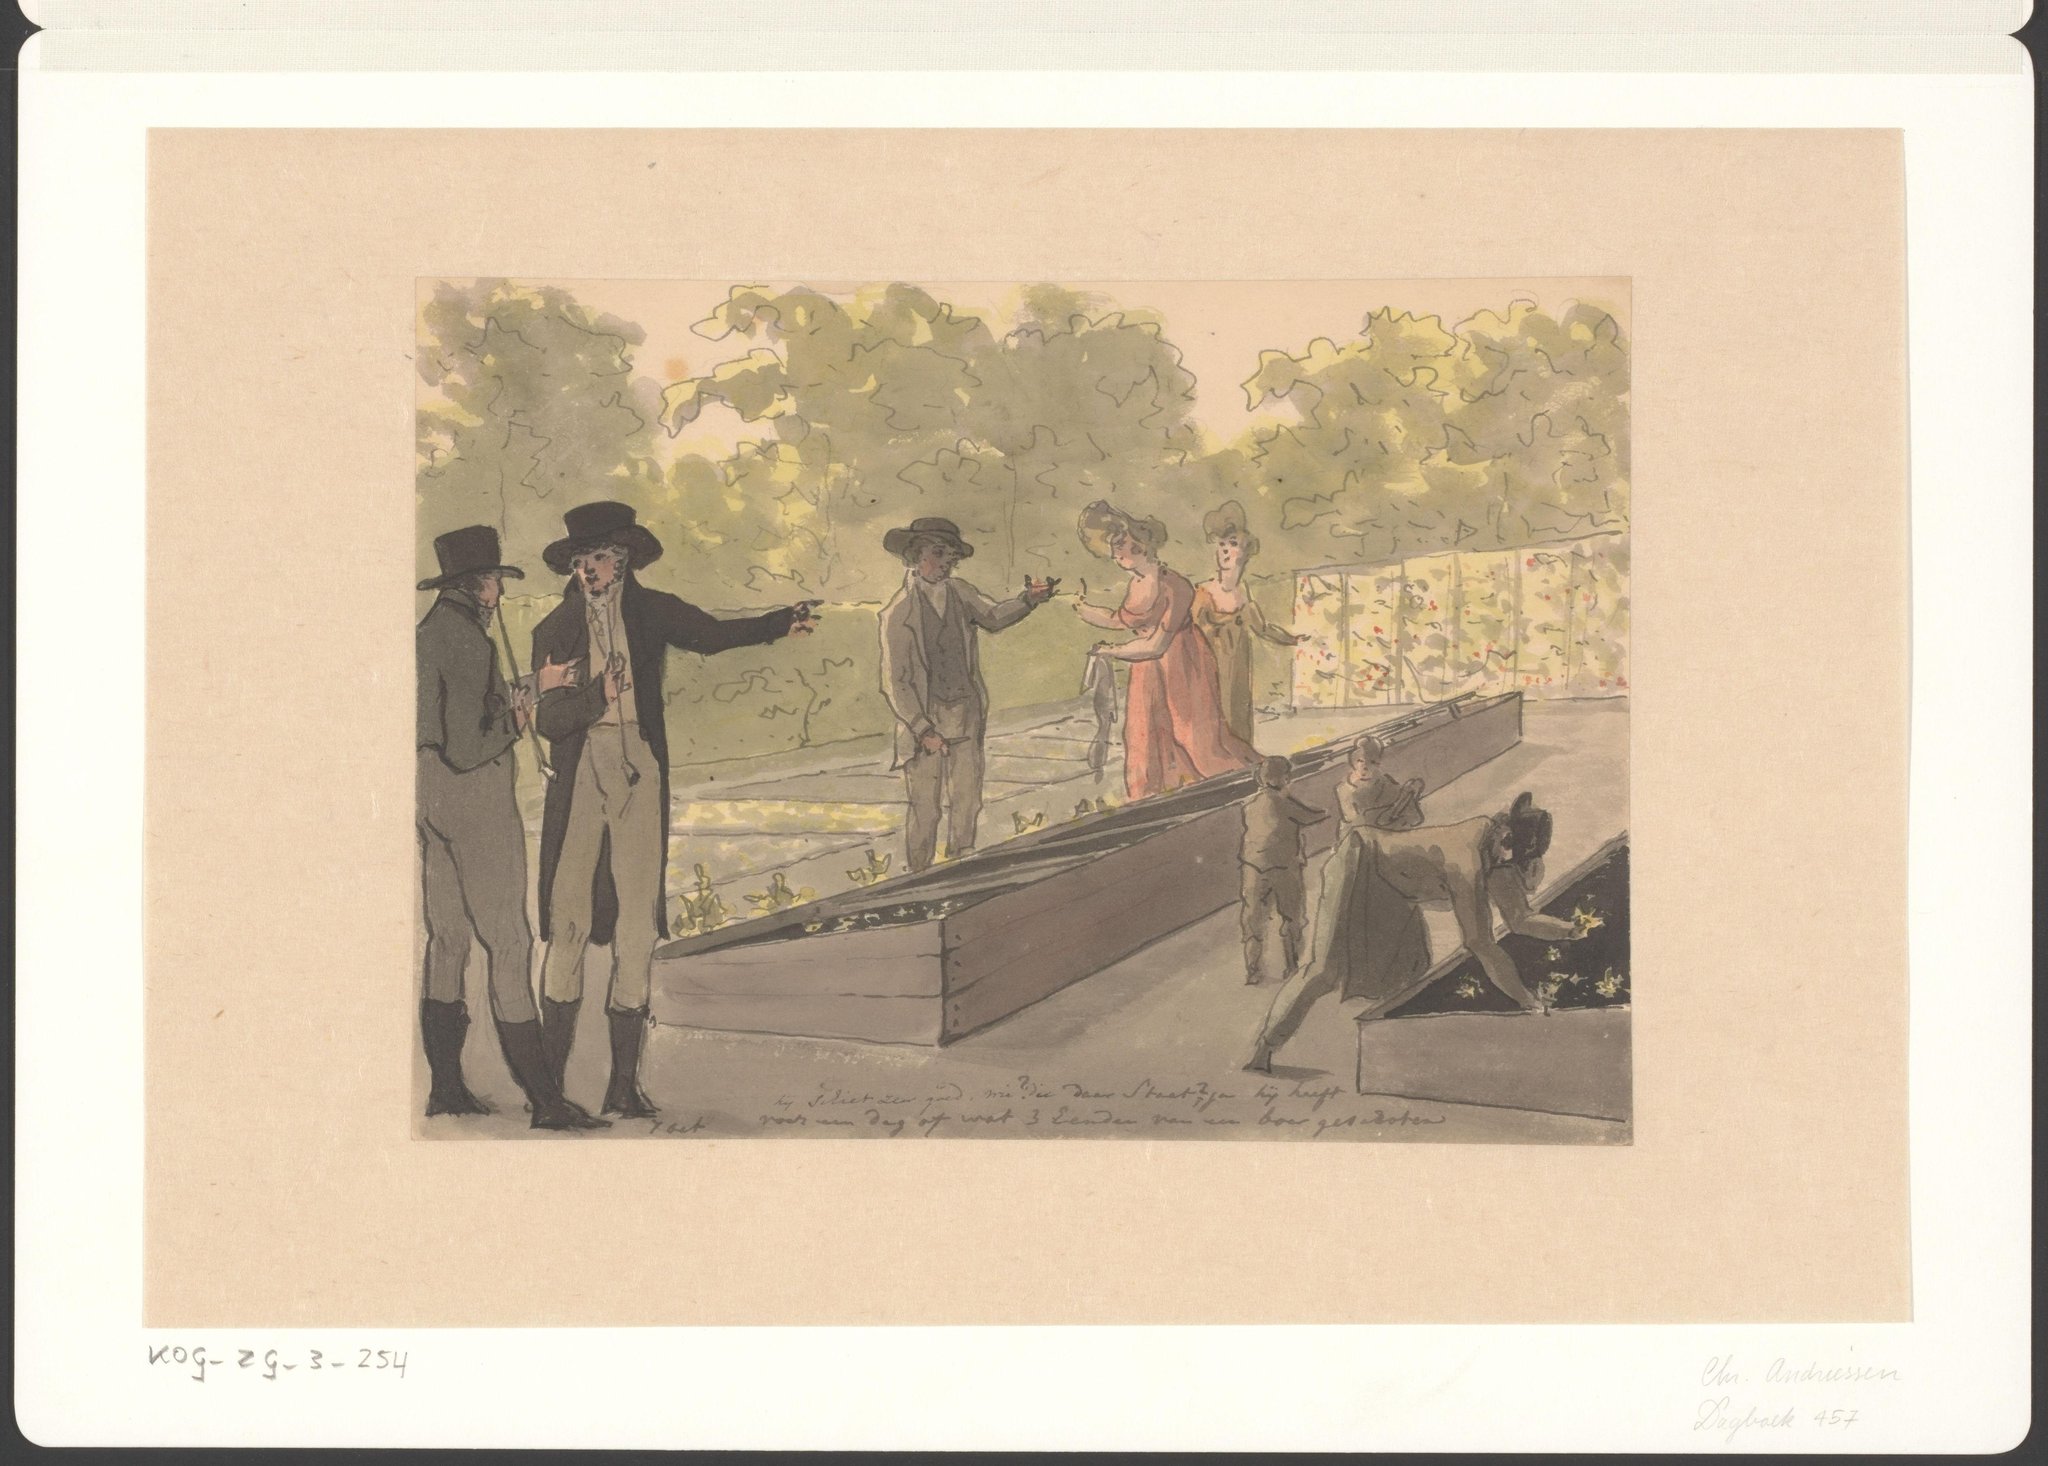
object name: drawing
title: Bezoek aan een kwekerij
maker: christiaan andriessen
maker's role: draughtsman, print maker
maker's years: 1775-1846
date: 1805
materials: ink, paper, pencil, watercolor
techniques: brush, pen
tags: amsterdam, print maker, draughtsman, christiaan andriessen, gardening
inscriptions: inscription: ‘7 oct hij schiet zeer goed, wie?’, signature: ‘J Andriessen’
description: Dagboekblad uit het getekende dagboek dat Christiaan Andriessen bijhield van 1805 tot en met 1808.